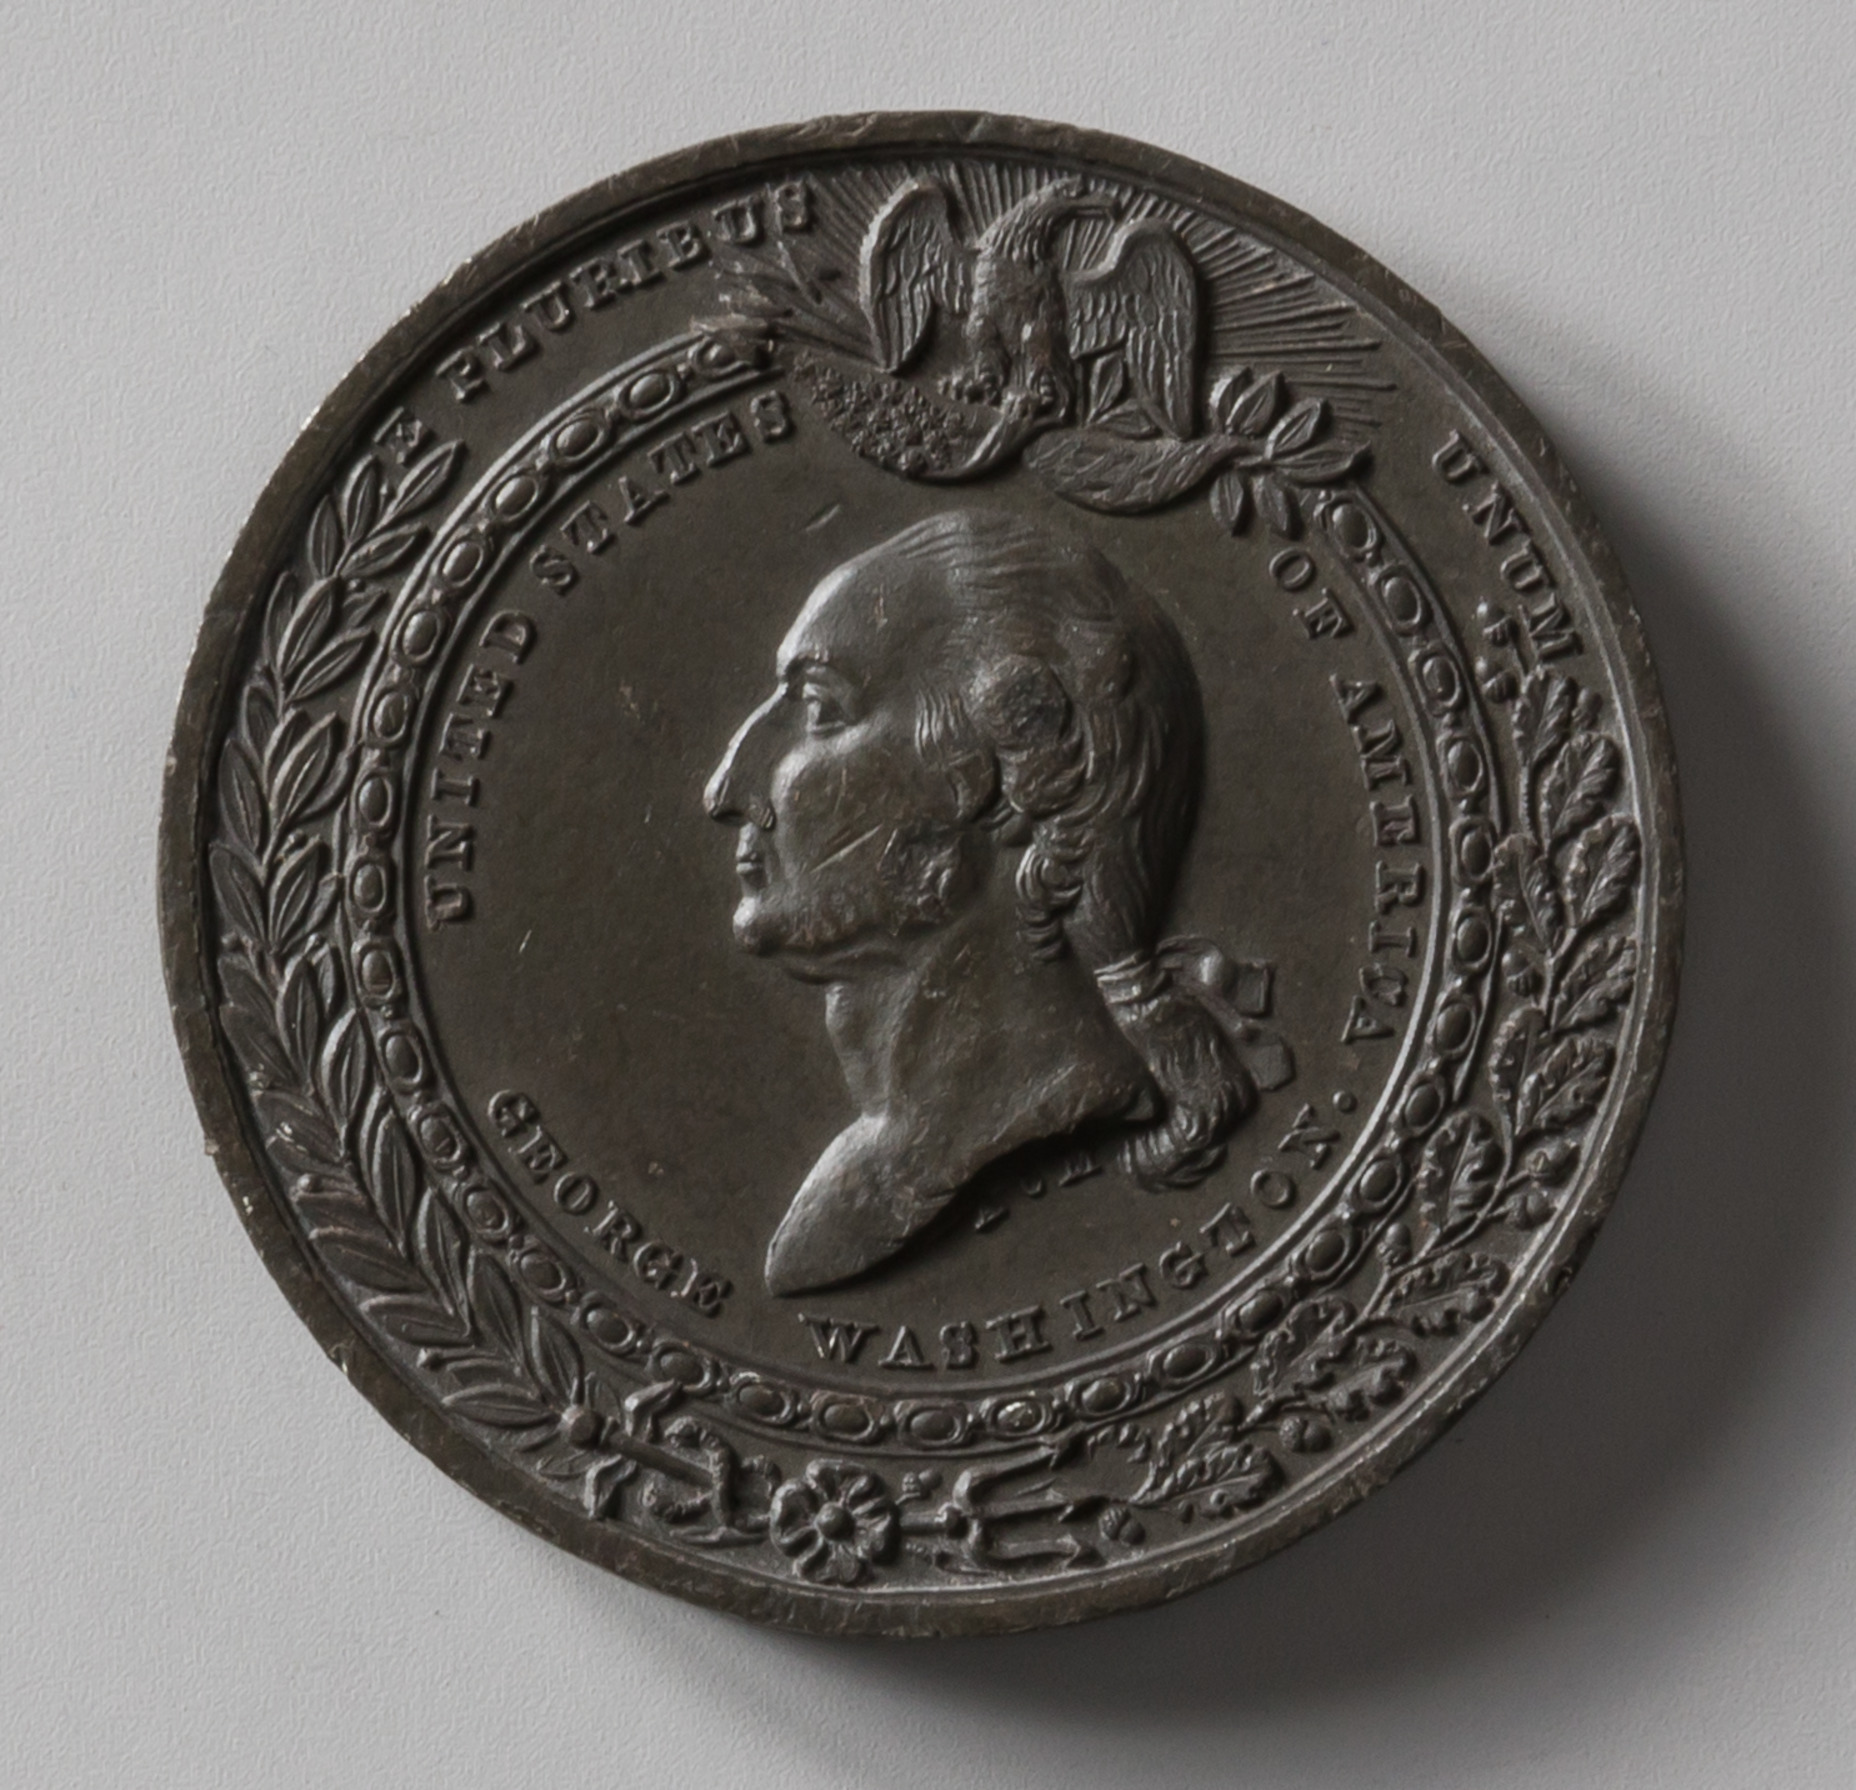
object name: medal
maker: anthony paquet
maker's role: maker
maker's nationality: american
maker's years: 1814-1882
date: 1853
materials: metal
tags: eagles,george washington,men,profiles